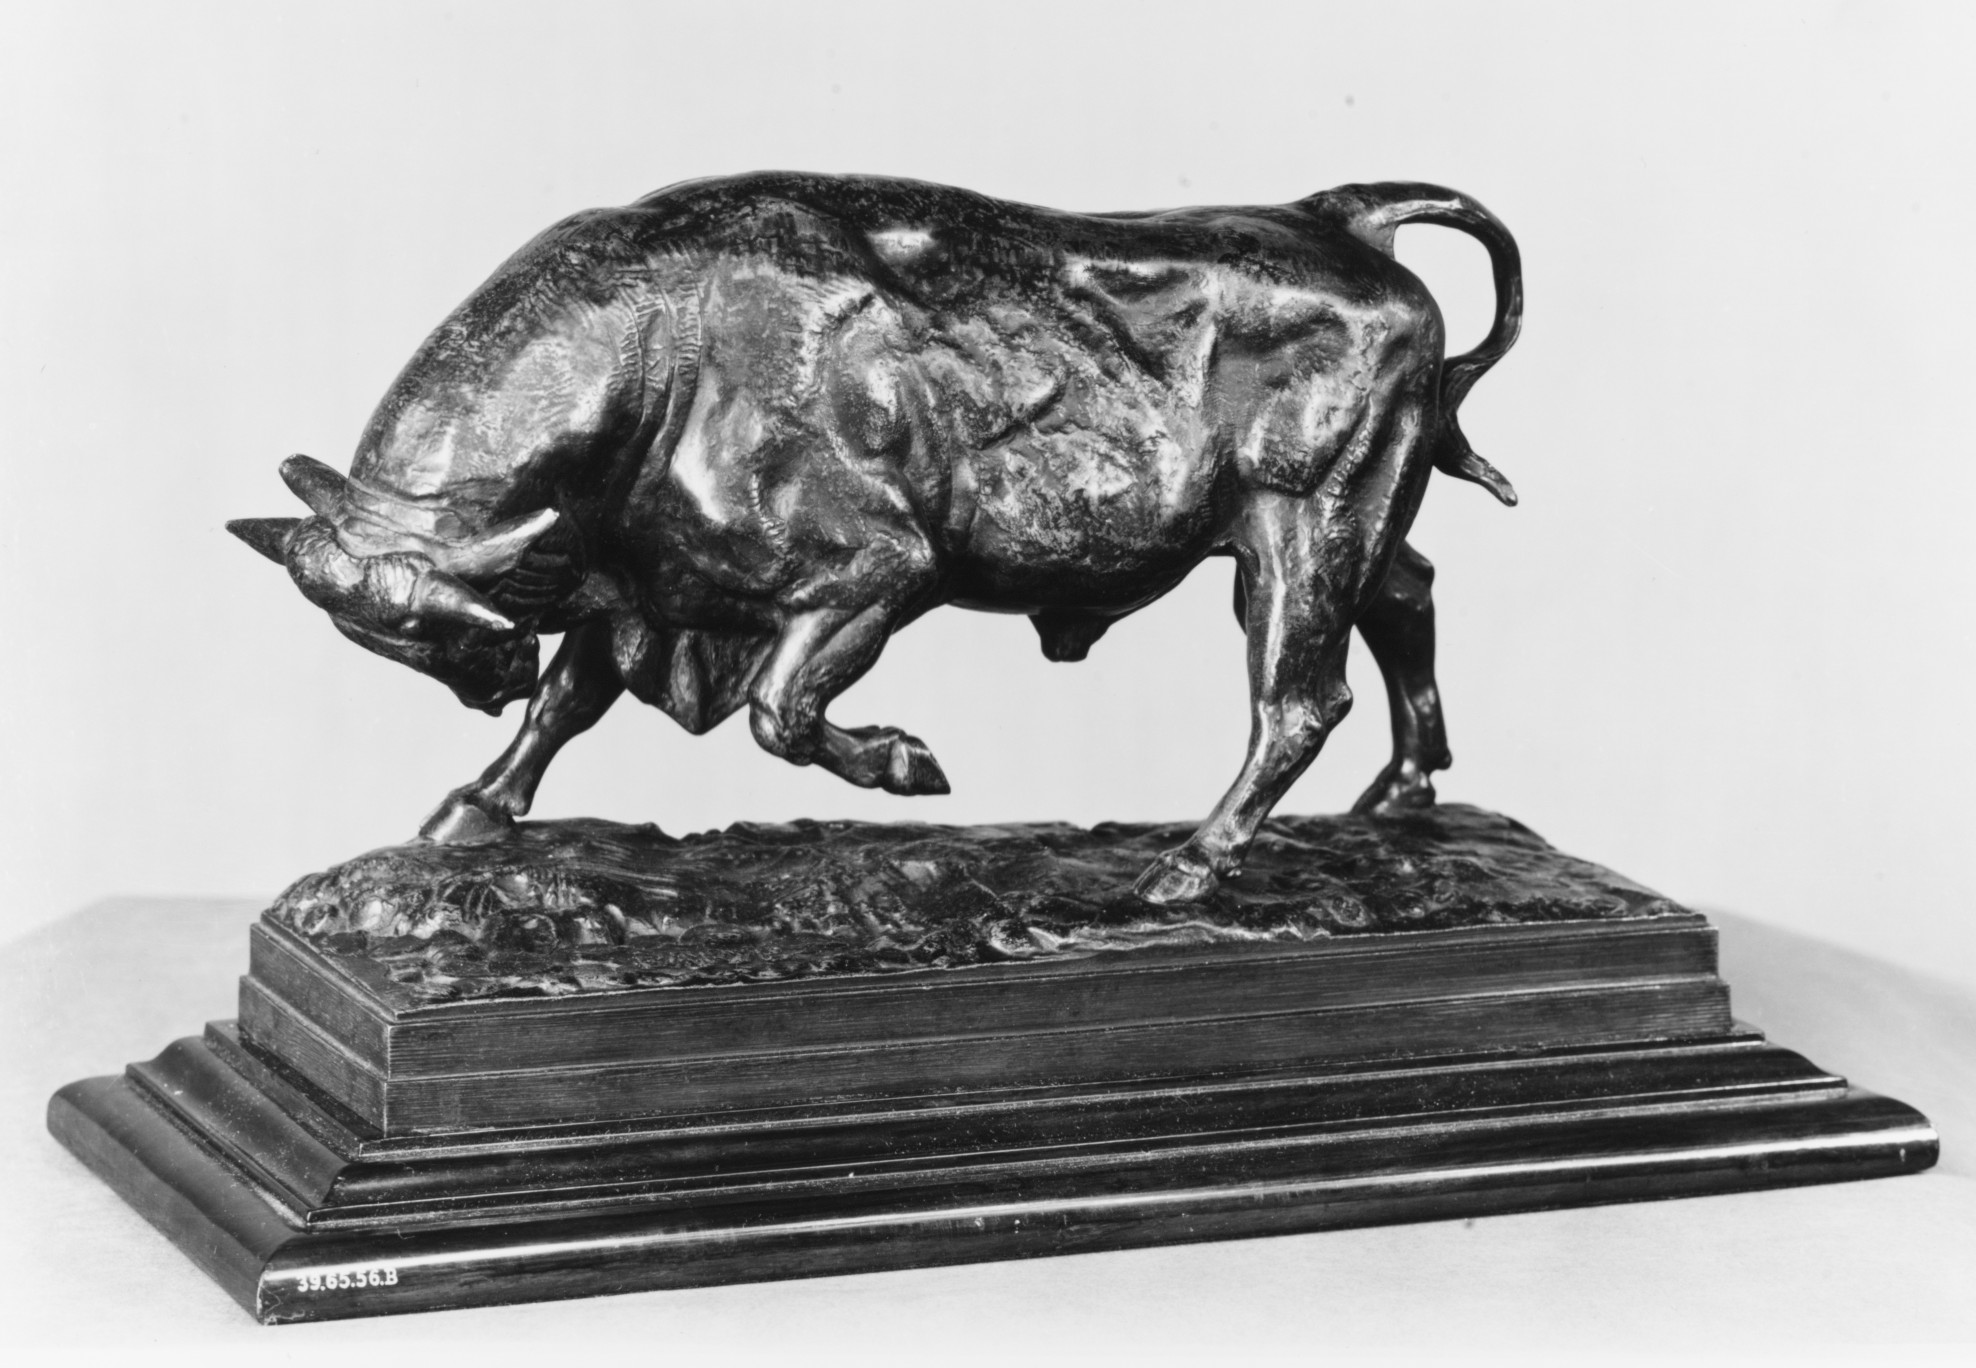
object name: statuette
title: Bull on the Defensive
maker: antoine-louis barye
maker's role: artist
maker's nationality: french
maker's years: 1795-1875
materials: bronze, patina, wood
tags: bulls